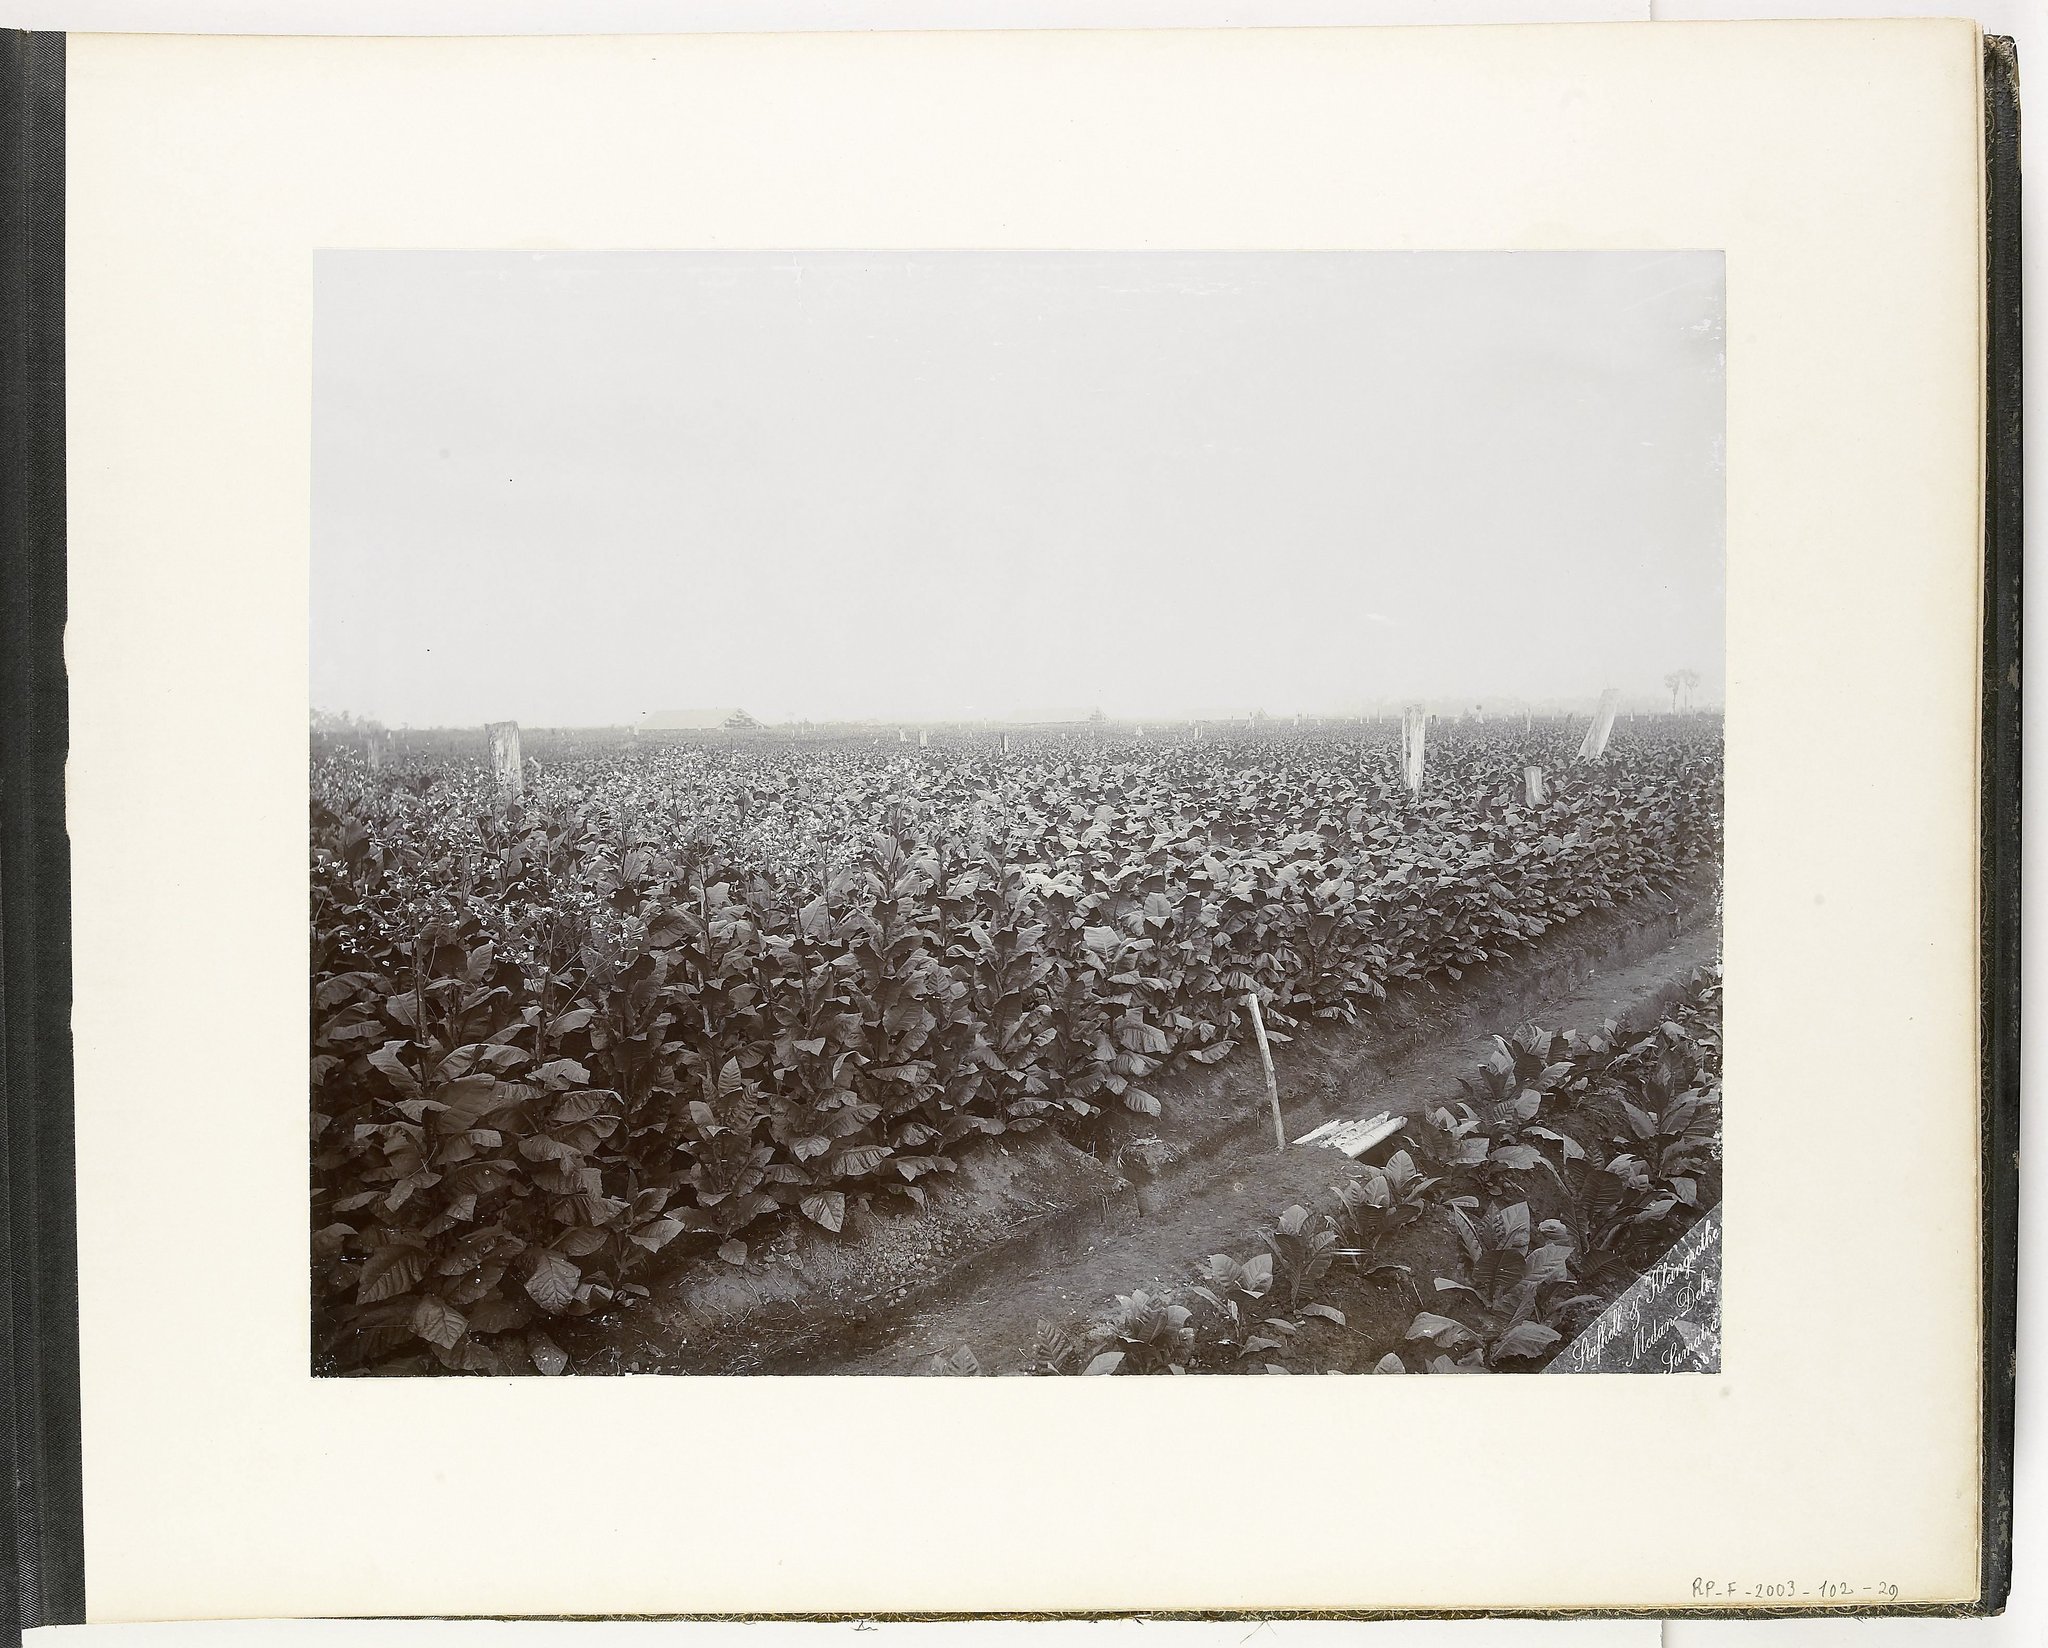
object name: photograph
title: Gezicht op de rijtjes ingezaaide bomen bij Soengei Dirki Sumatra (Saatbaüme Soengei Dirki)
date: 1890-1900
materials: photographic support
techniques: collodion silver print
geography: sumatra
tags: sumatra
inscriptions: signature: ‘Stafhell & Kleingrothe Medan-DEli’, number: ‘Sumatra 38.’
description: Velden met bloeiende tabaksplanten op een plantage bij Soengei Dirki op Sumatra. Onderdeel van het Sumatra fotoalbum van Paul en Lucie Sandel uit 1900.